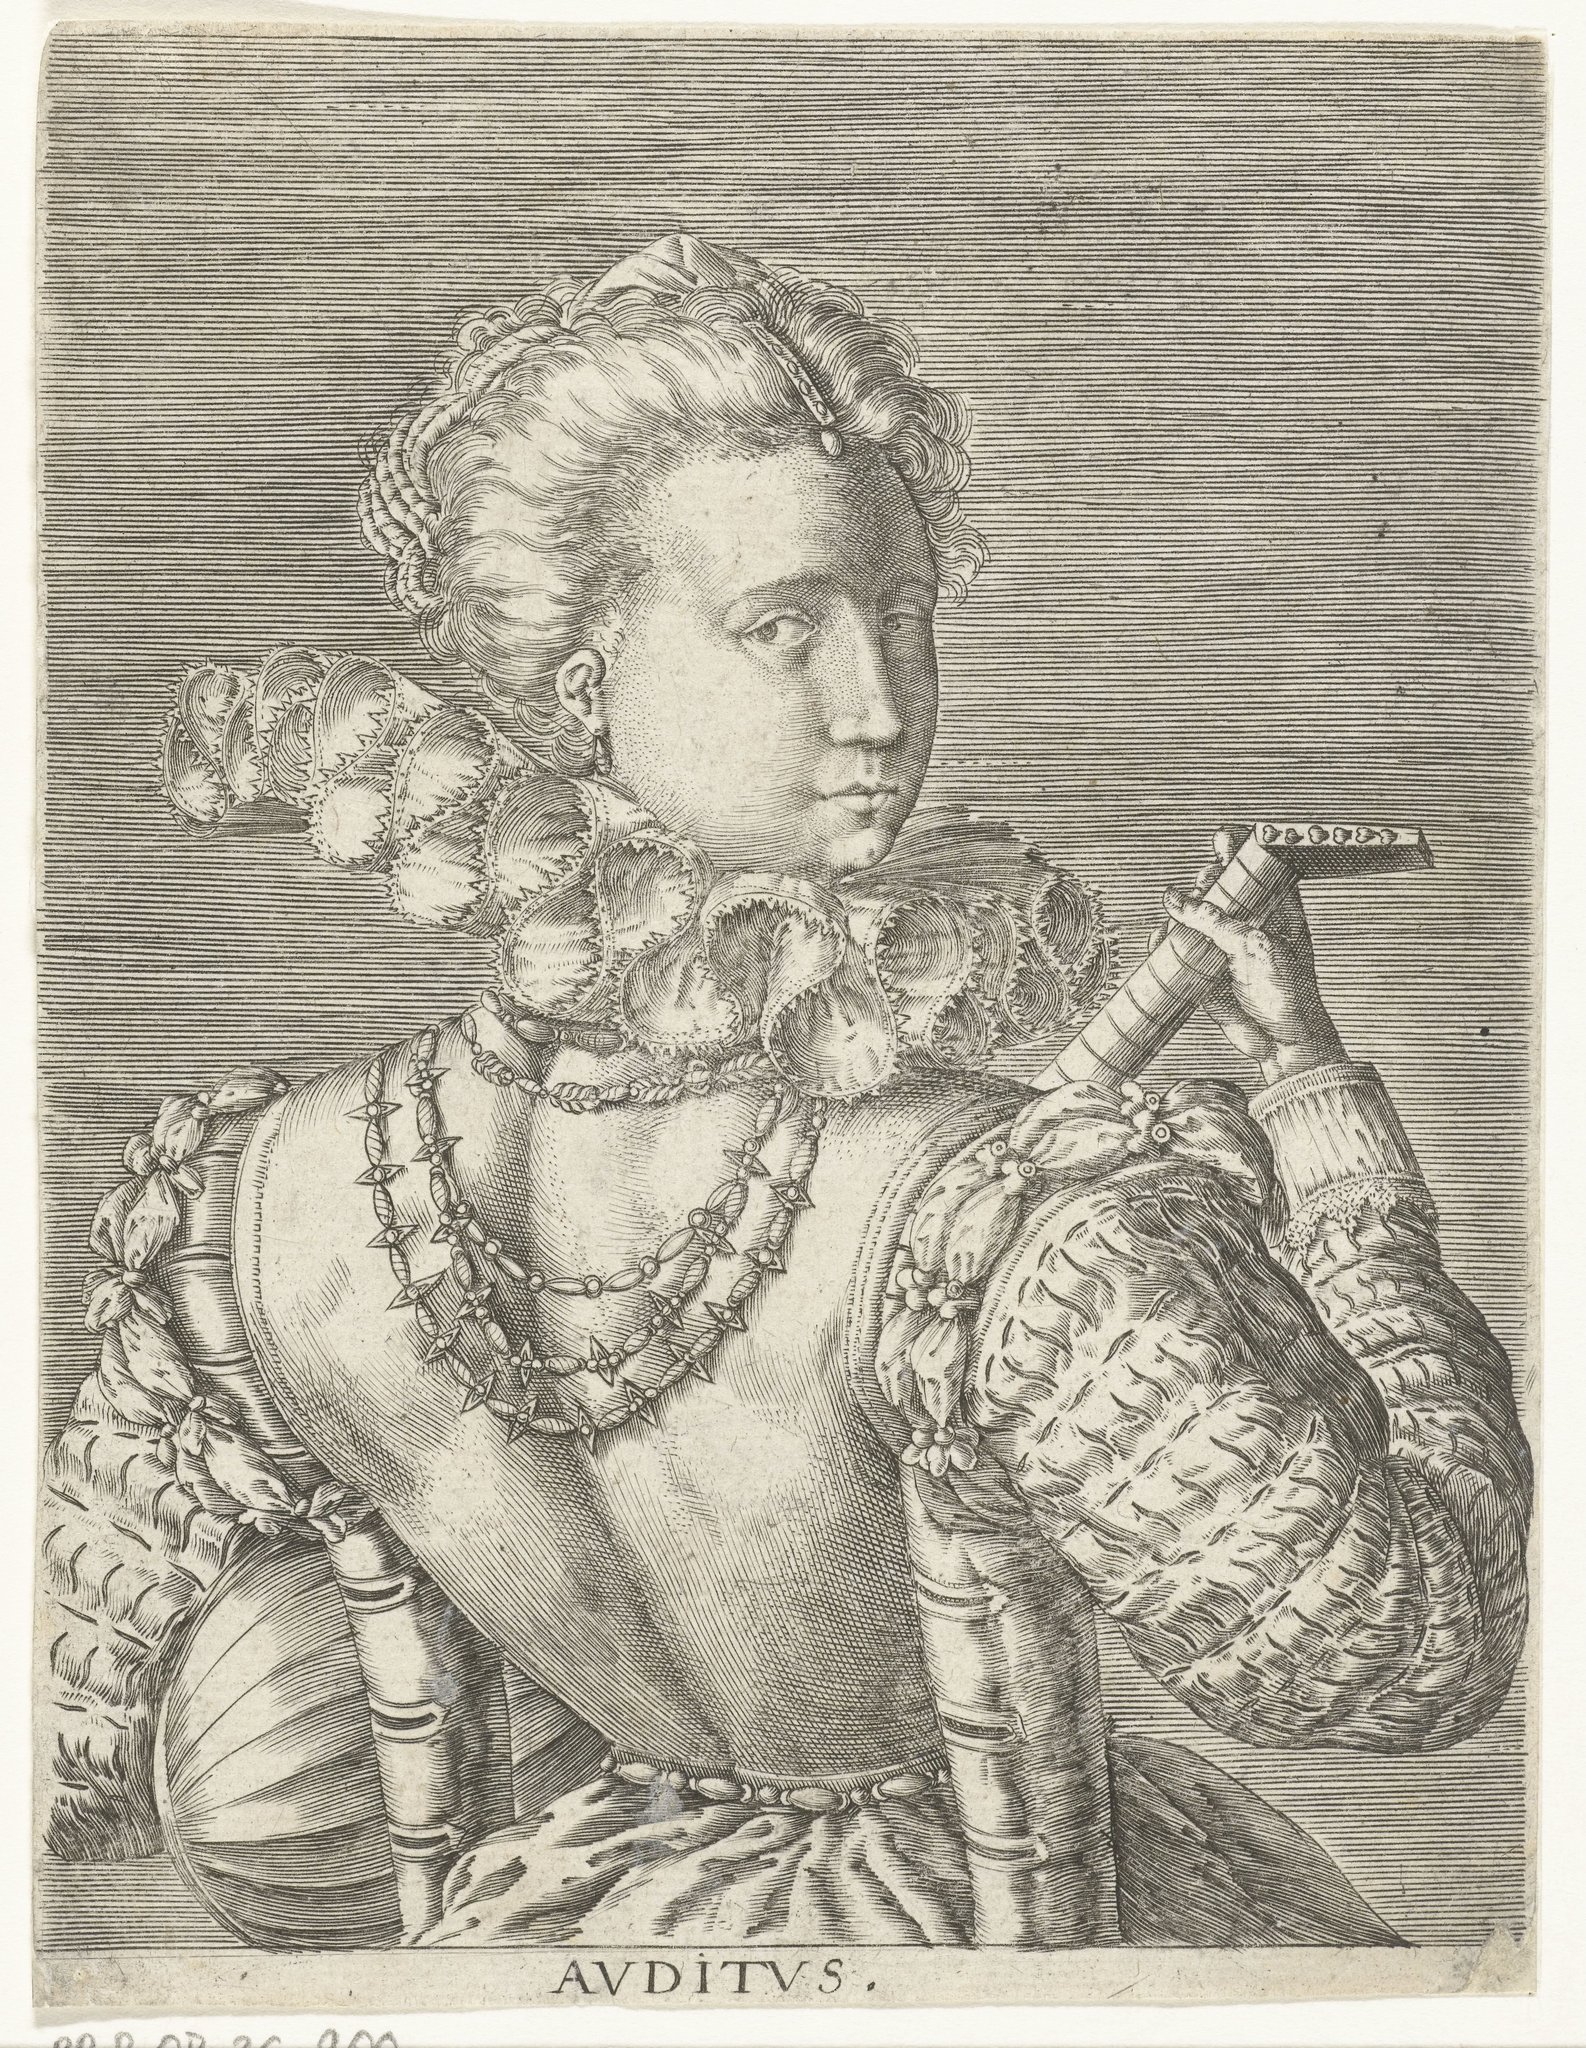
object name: print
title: Gehoor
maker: Anonymous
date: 1550-1650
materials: paper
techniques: engraving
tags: hearing, listening (one of the five senses), sleeves, neck-gear ~ clothing (with name) (+ women's clothes), hairdress - aa - ~ women, one person playing string instrument (plucked), lute, and special forms of lute, e.g.: theorbo, necklace (+ women's clothes), clothing for the upper part of the body (with name) (+ women's clothes), ear-rings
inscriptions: collector's mark: Lugt 2228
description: Kleding: Kapsel met achterover gekamd haar, waarop, op het achterhoofd, een mutsje met parel op het voorhoofd. Verschillende kettingen. Oorbel. Overdreven wijde, los geplooide kraag* . Siermouwen.